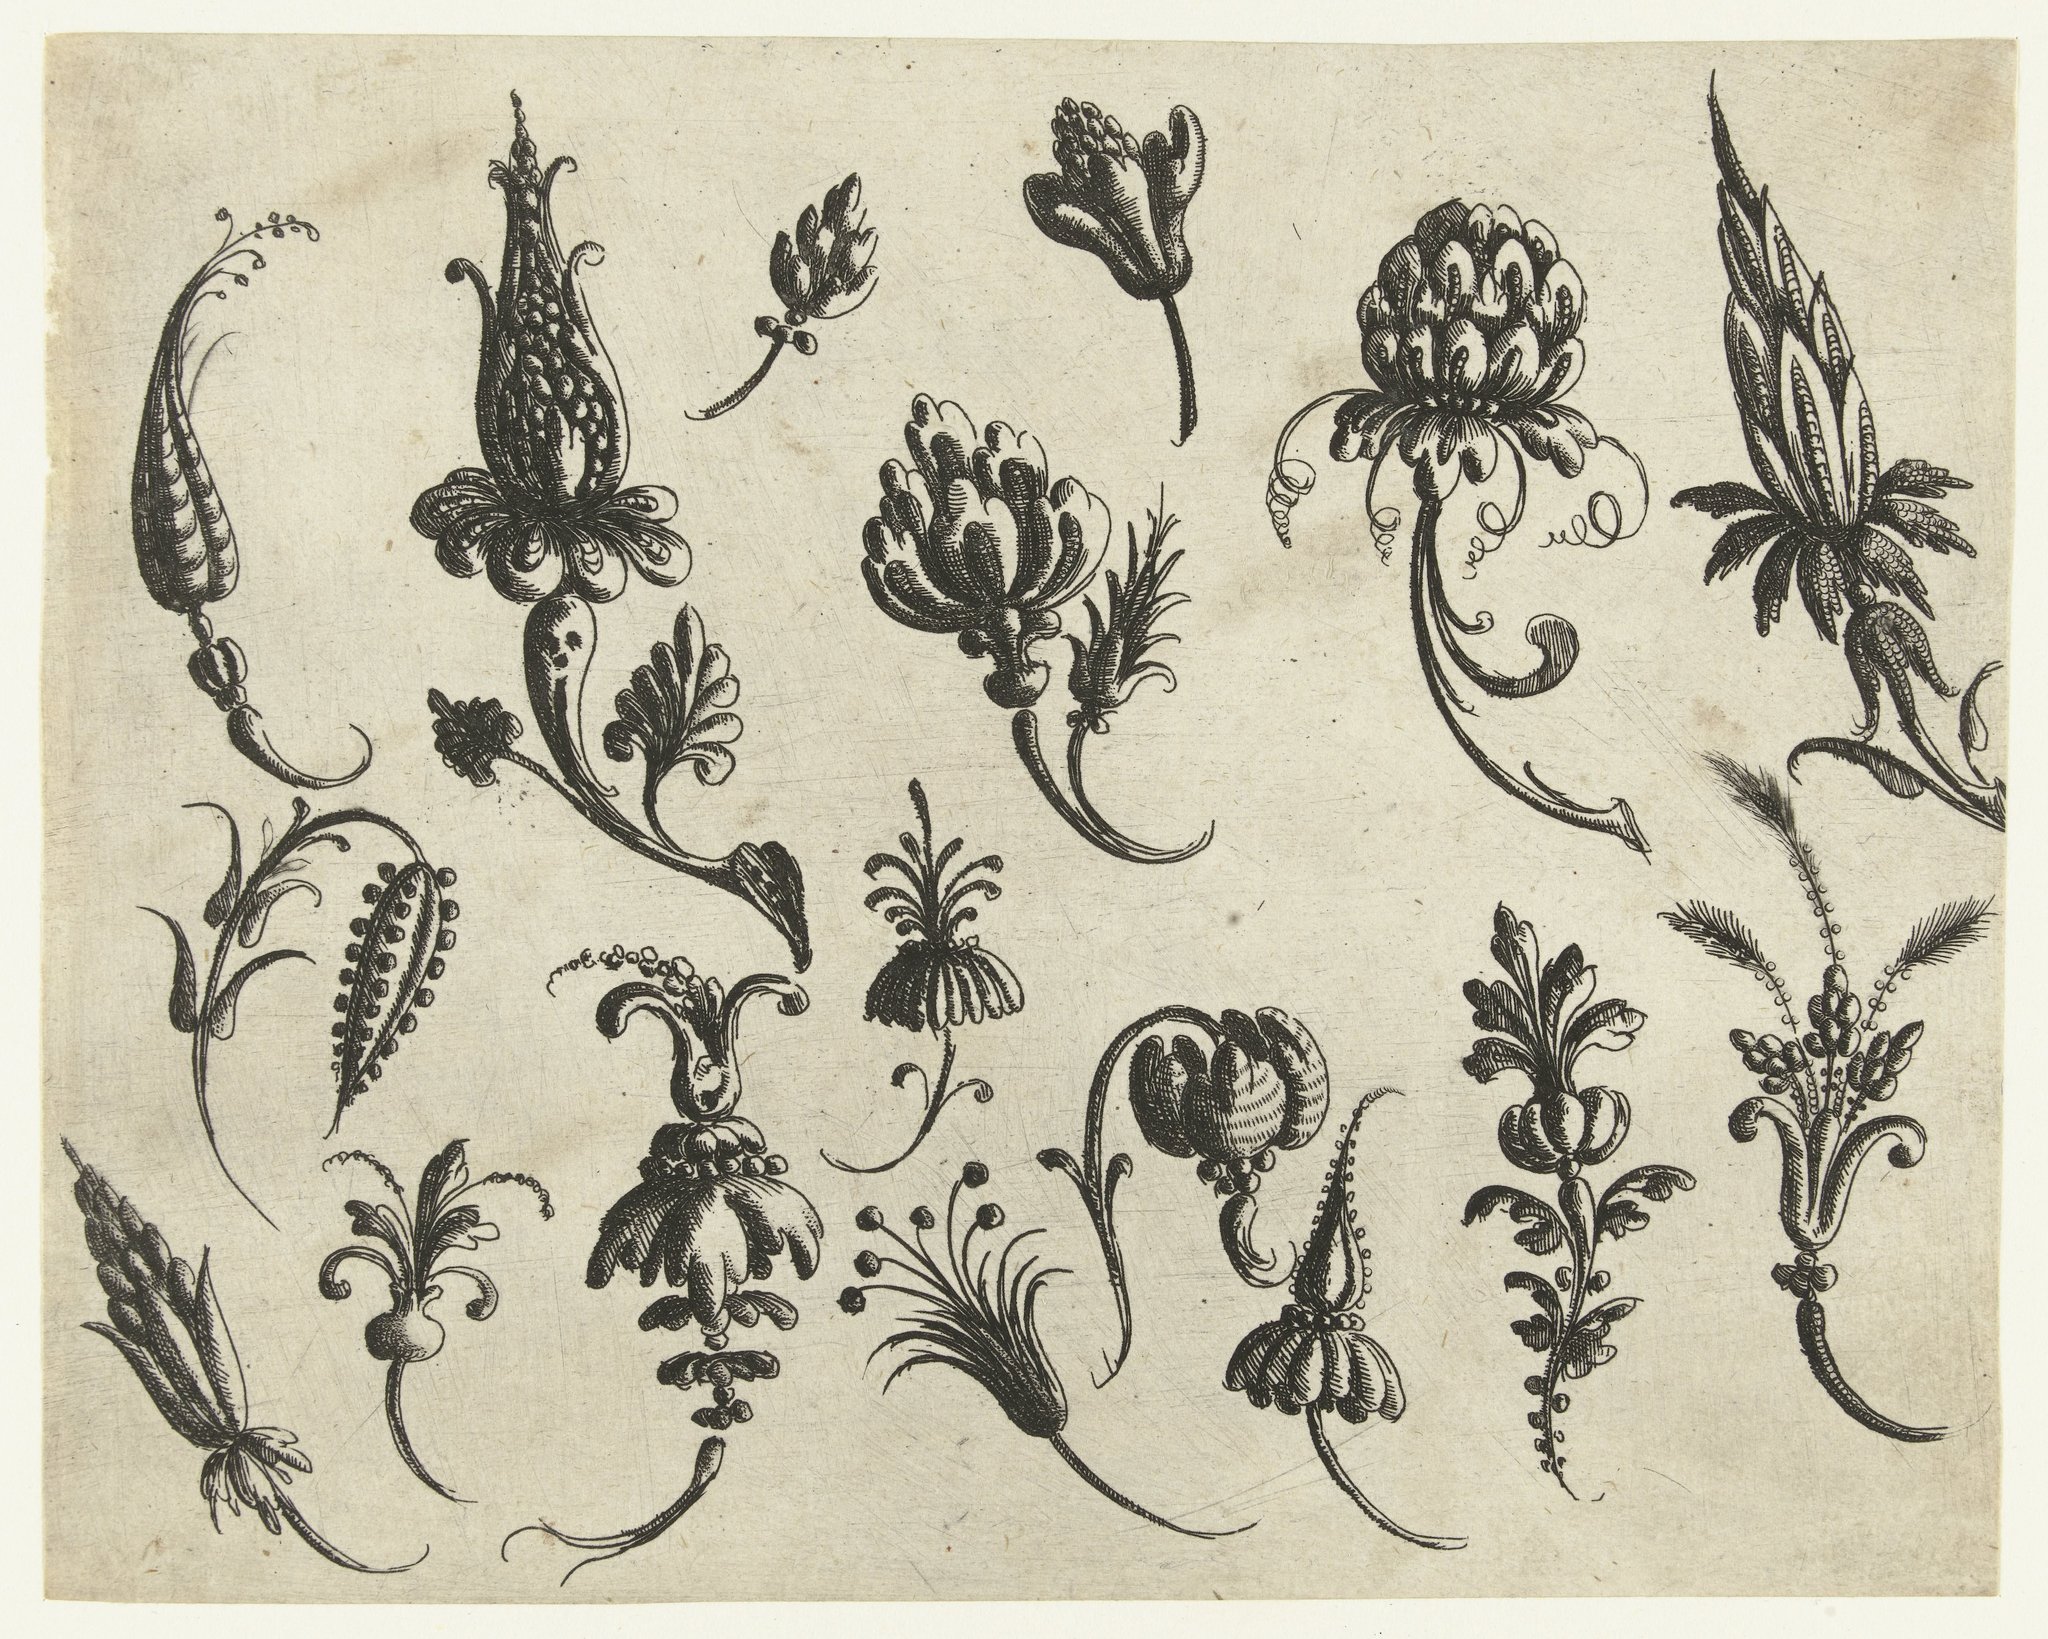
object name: ornament print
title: blad van het "Neu Grotesken Buch" 1610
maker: christoph jamnitzer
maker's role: draughtsman, goldsmith, print maker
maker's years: 1563-1618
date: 1573-1610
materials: paper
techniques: etching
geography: germany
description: Blad uit een serie vlakdecoraties met grotesken, cartouches, ovalen, mascarons, putti en fantastische wezens. De serie bestaat uit drie titelbladen, twee tekstbladen met de opdracht en het voorwoord en 60 bladen, verdeeld over drie boeke